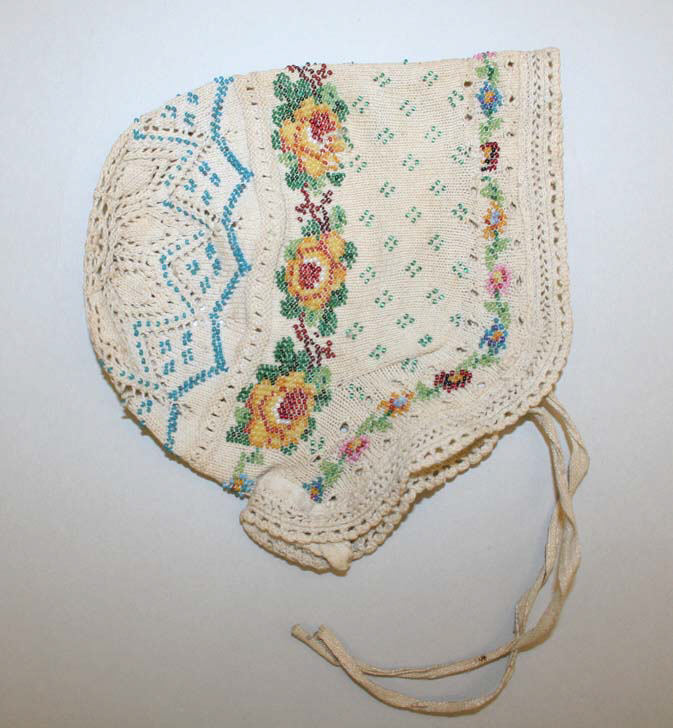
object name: christening cap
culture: european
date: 1801-1833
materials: cotton, glass, linen